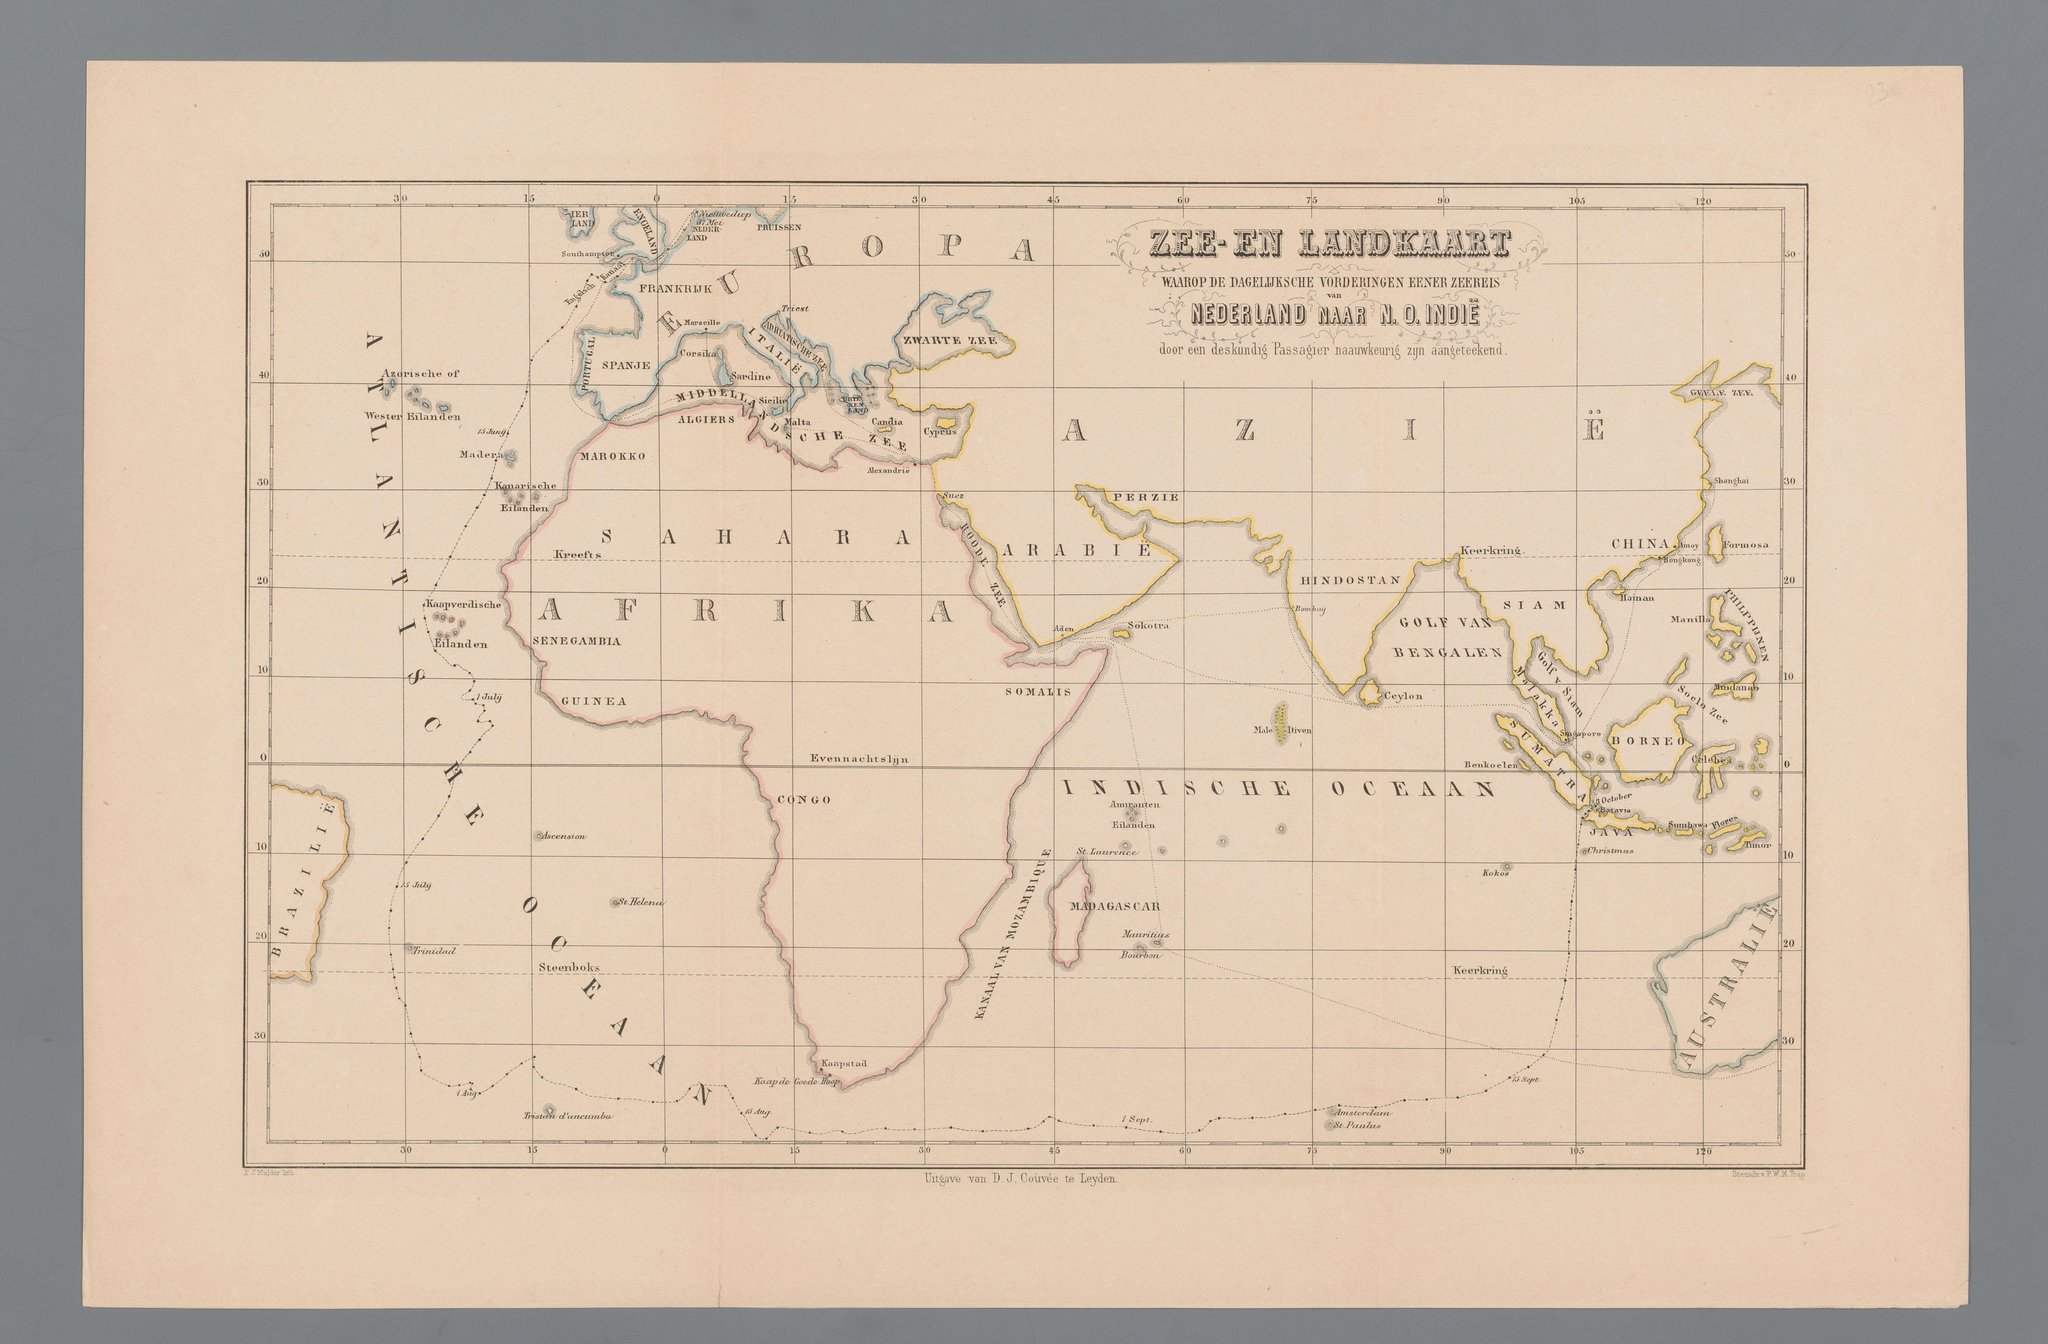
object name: map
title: Zee- en landkaart waarop de dagelijksche vorderingen eener zeereis van Nederland naar N.O. Indië door een deskundig Passagier naauwkeurig zijn aangeteekend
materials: paper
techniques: lithograph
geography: leiden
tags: marine charts, maps of the continents and the polar regions, netherlands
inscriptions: collector's mark: Lugt 2760